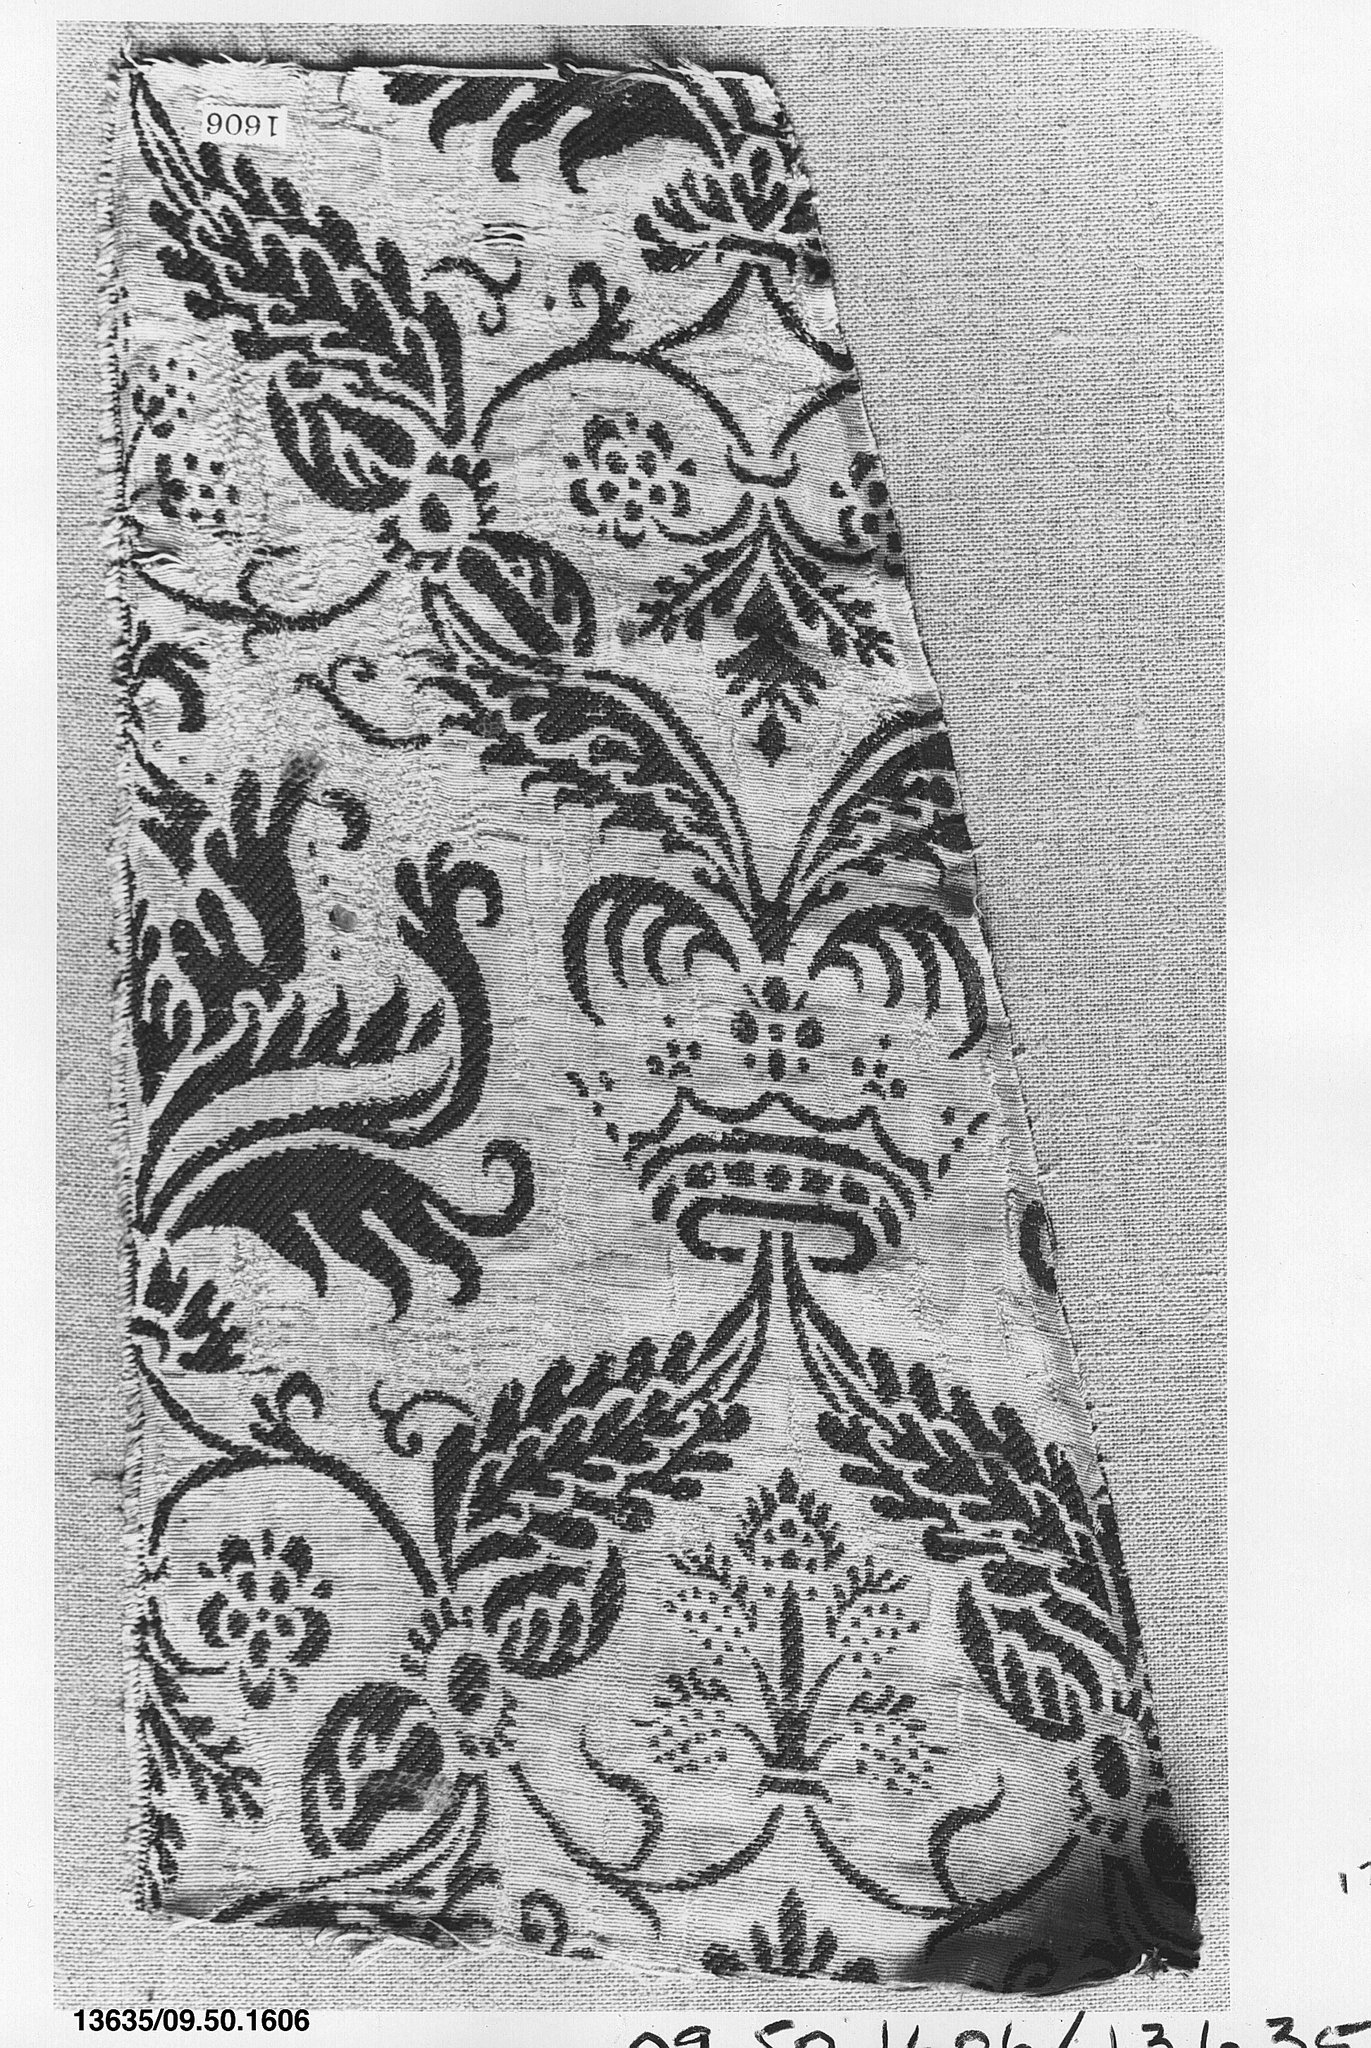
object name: piece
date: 1601-1700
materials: silk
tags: flowers,leaves